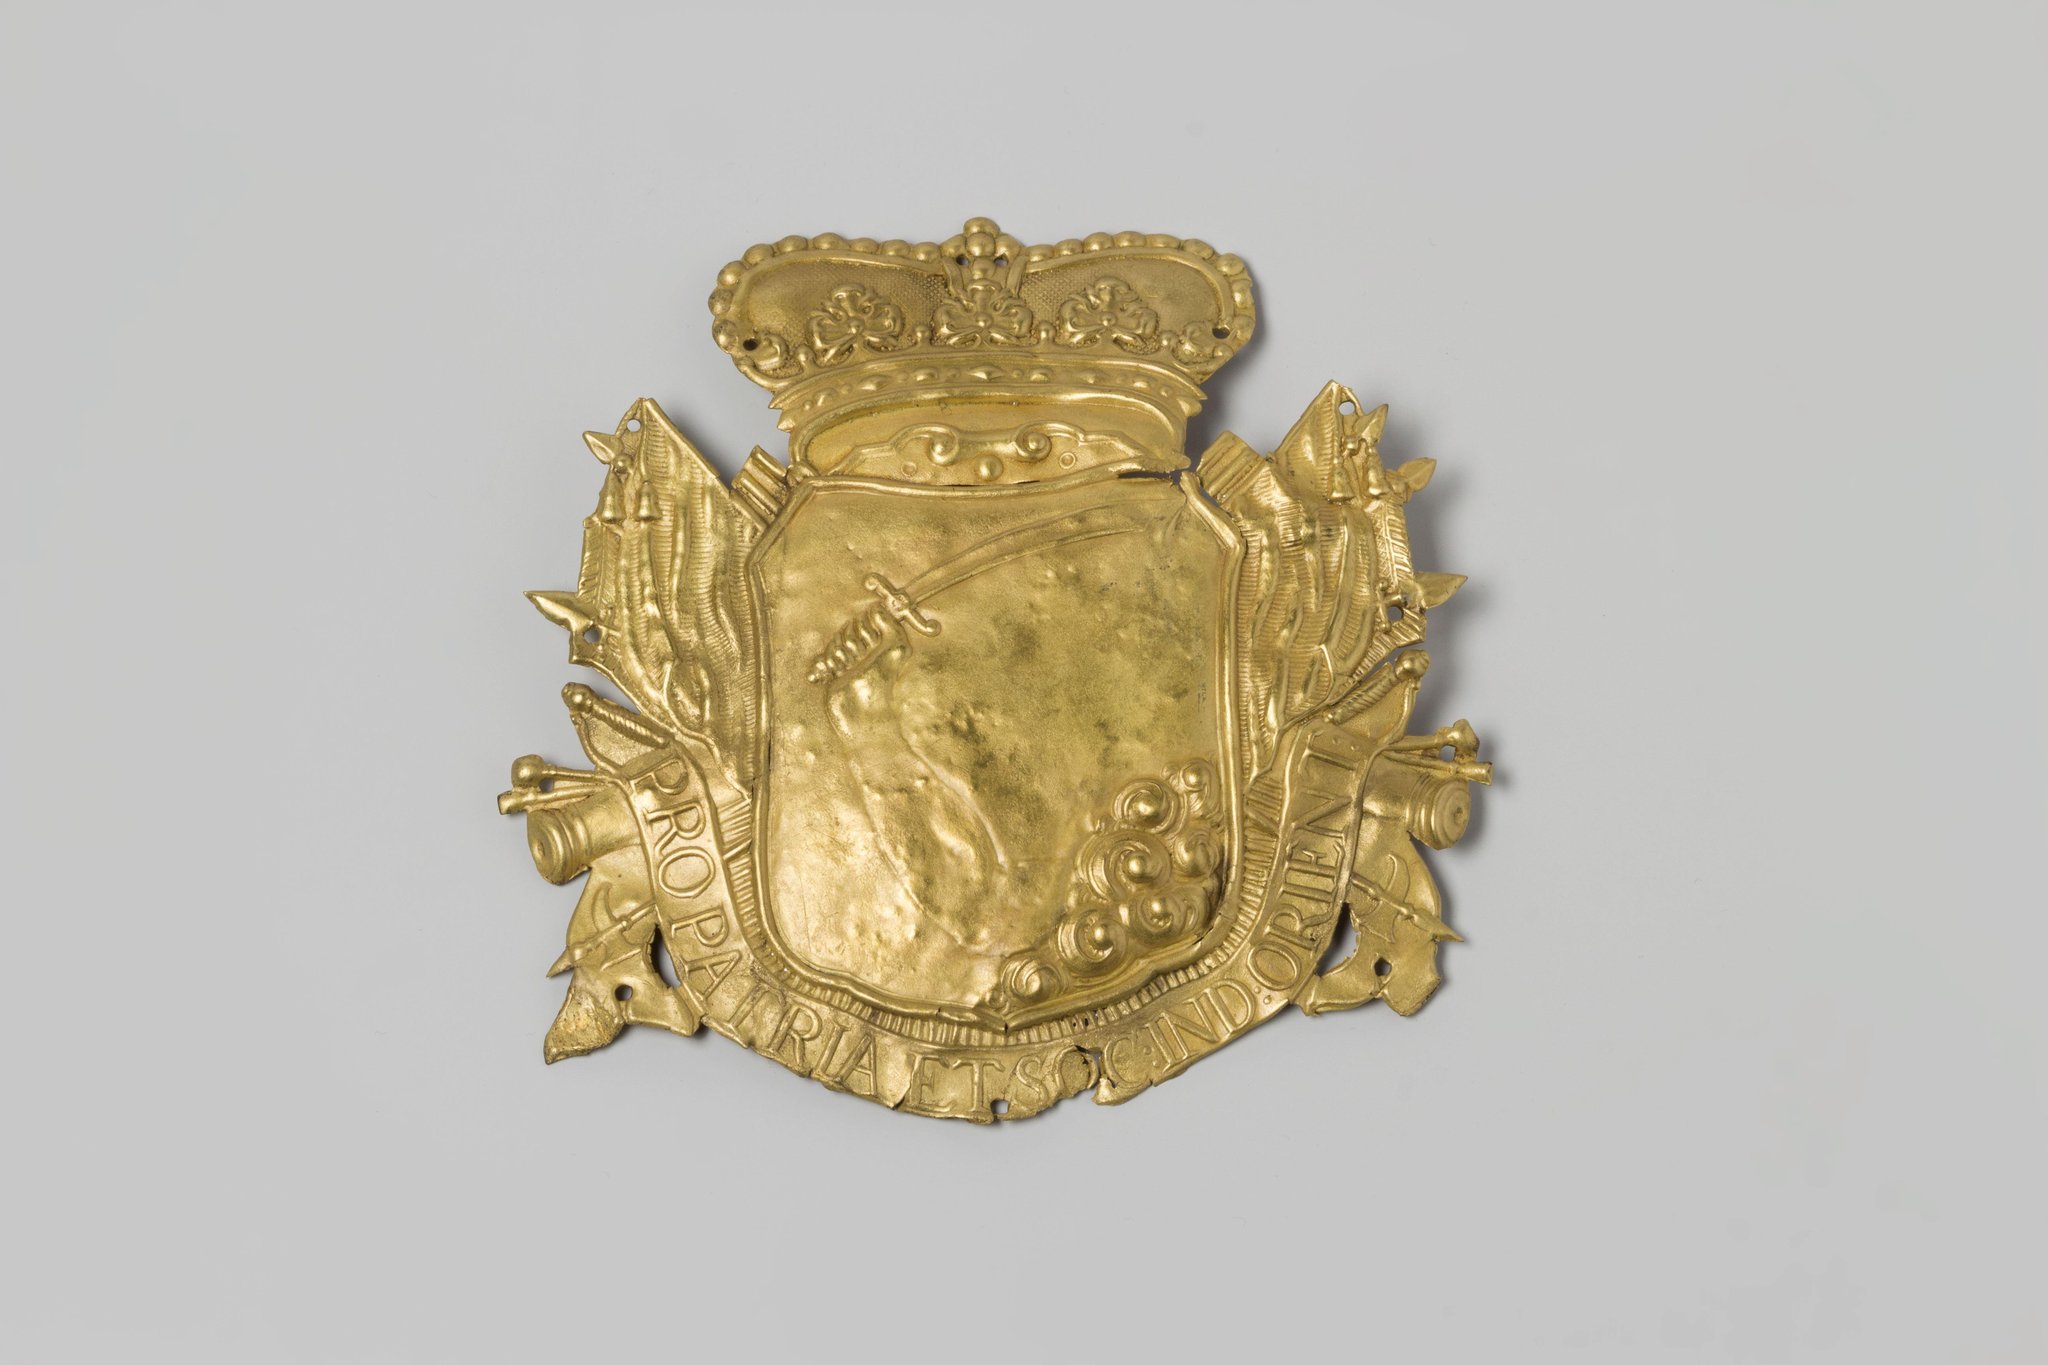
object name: insignia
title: Military insignia of a musketeer or grenadier from the wreck of the Dutch East Indiaman Hollandia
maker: Anonymous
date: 1700-1743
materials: copper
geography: netherlands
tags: verenigde oostindische compagnie, hollandia (schip), annet